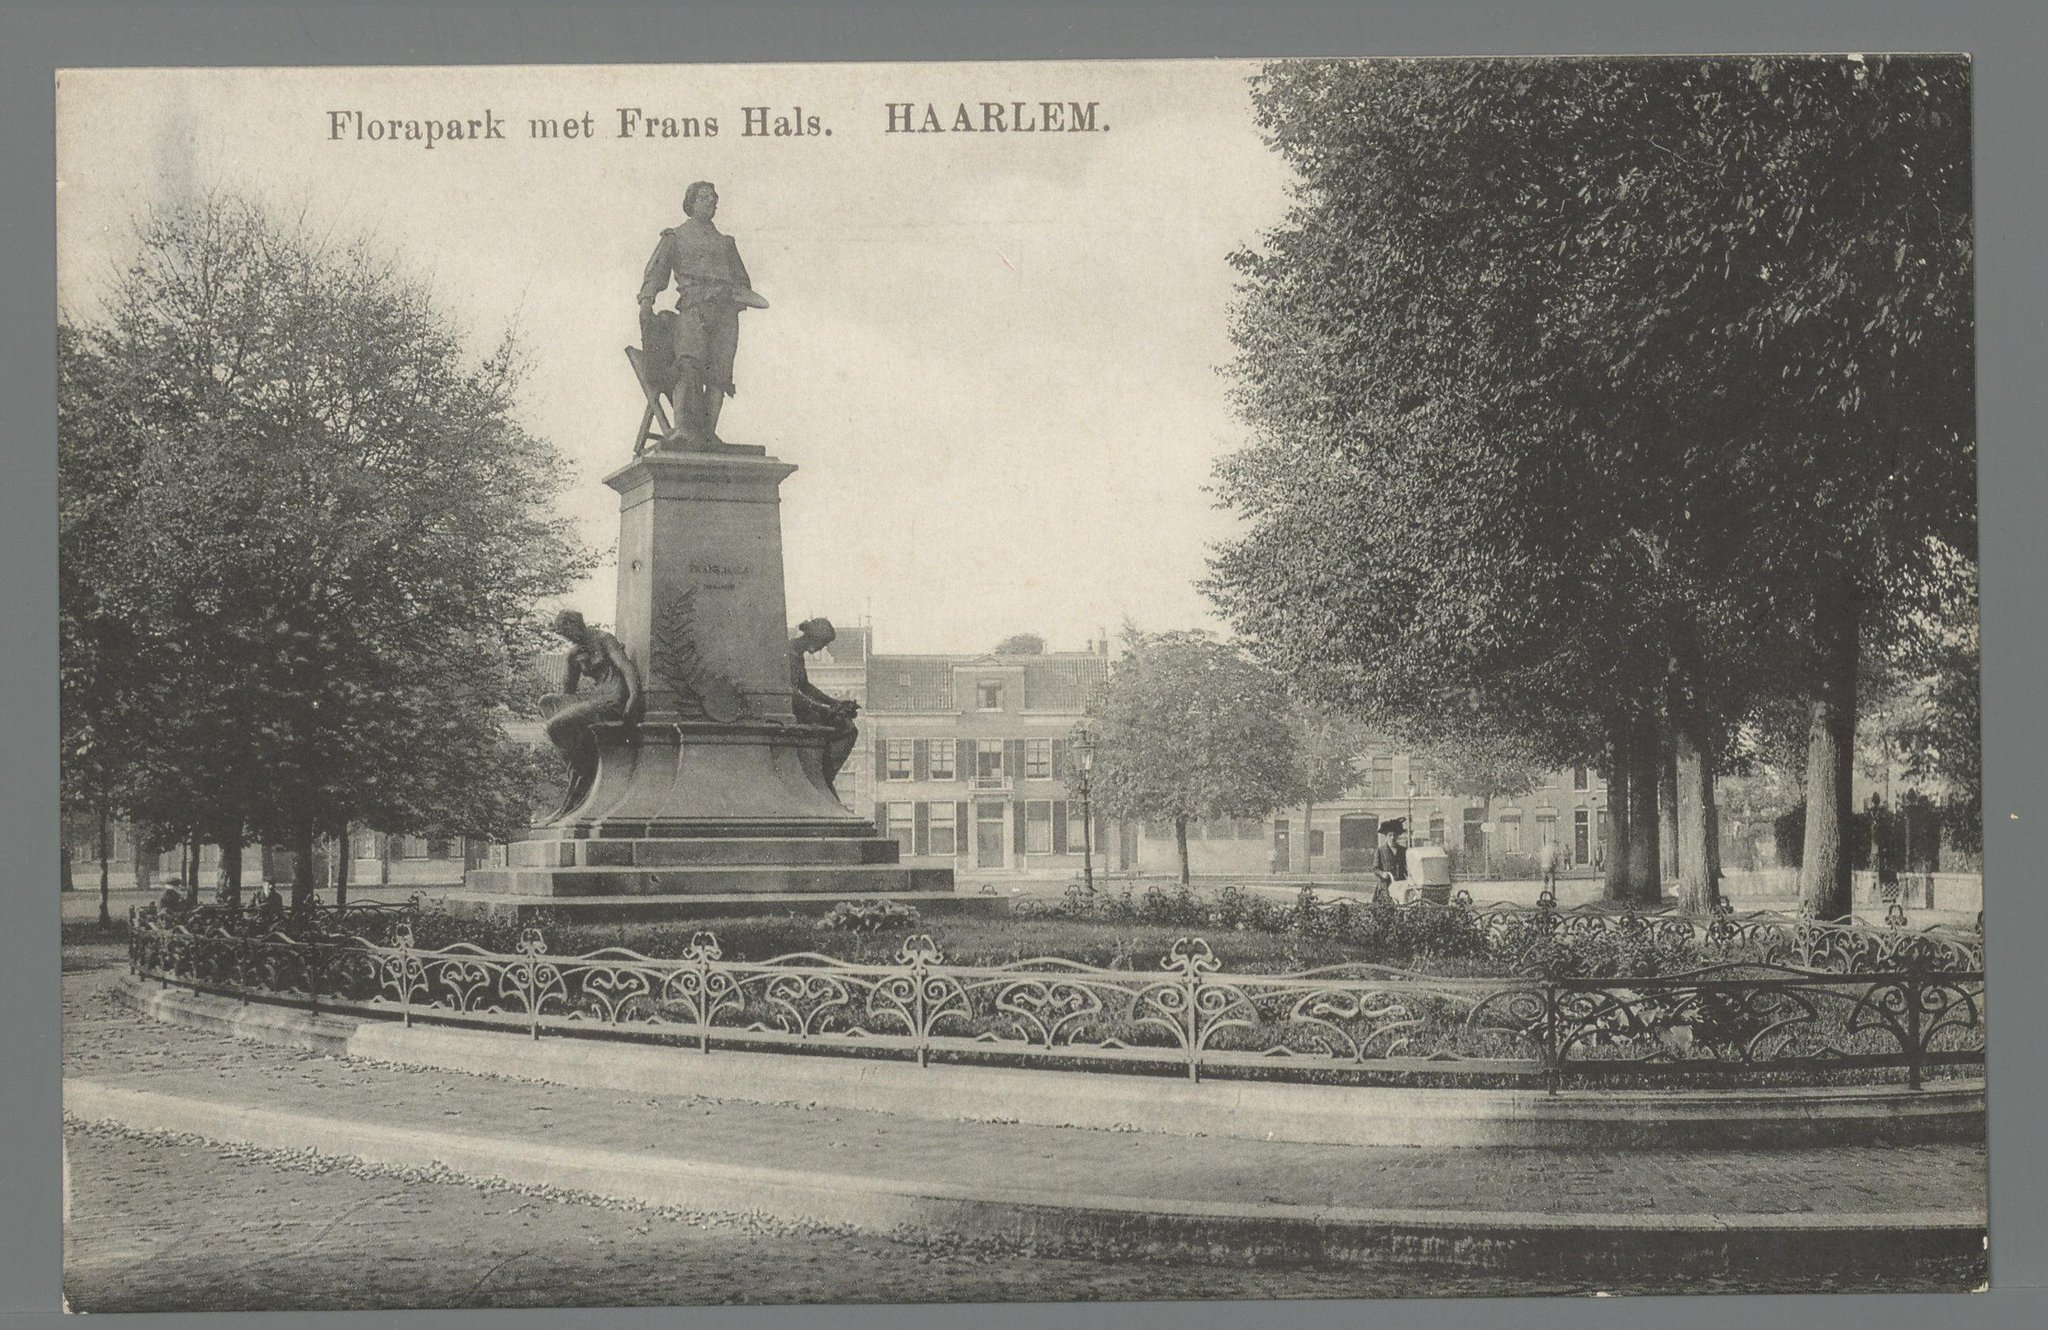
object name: photomechanical print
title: Florapark met Frans Hals. Haarlem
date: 1913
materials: cardboard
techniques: photograph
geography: haarlem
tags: antwerp, draughtsman, frans hals, park, monument, statue, haarlem